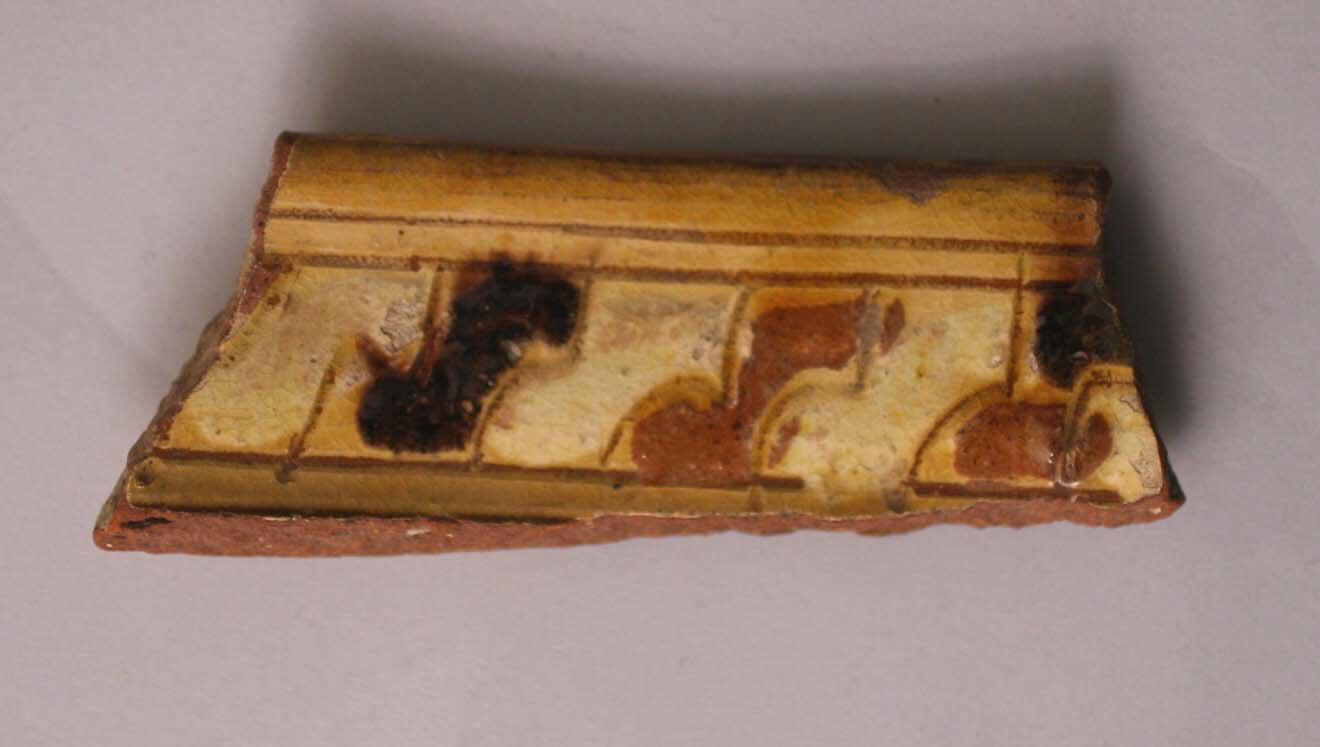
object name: fragment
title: Ceramic Fragment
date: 1301-1500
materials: earthenware, glaze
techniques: coloring, incising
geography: egypt